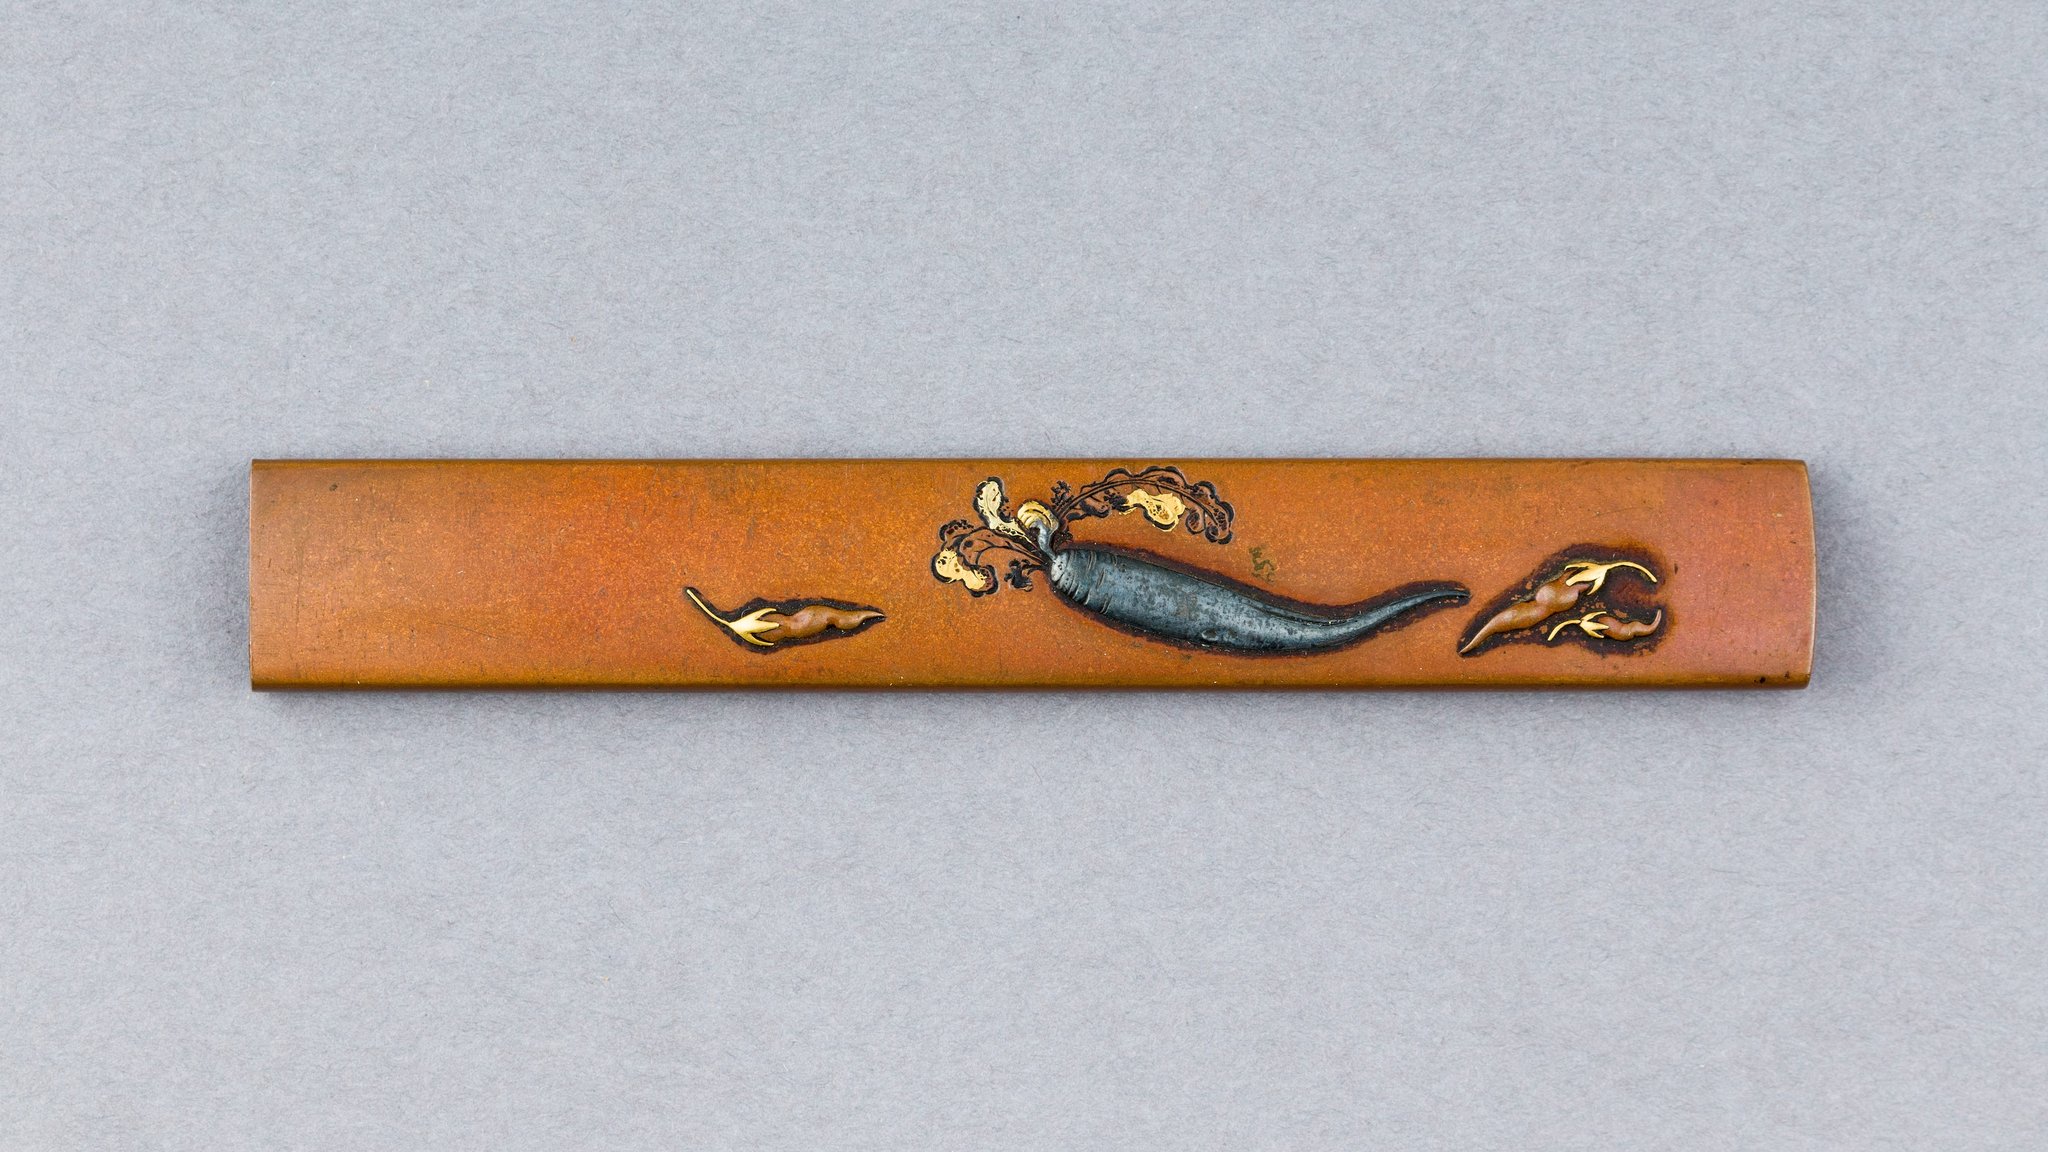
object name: knife handle kozuka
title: Knife Handle (Kozuka)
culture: japanese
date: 1615-1868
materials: copper, gold, silver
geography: japan